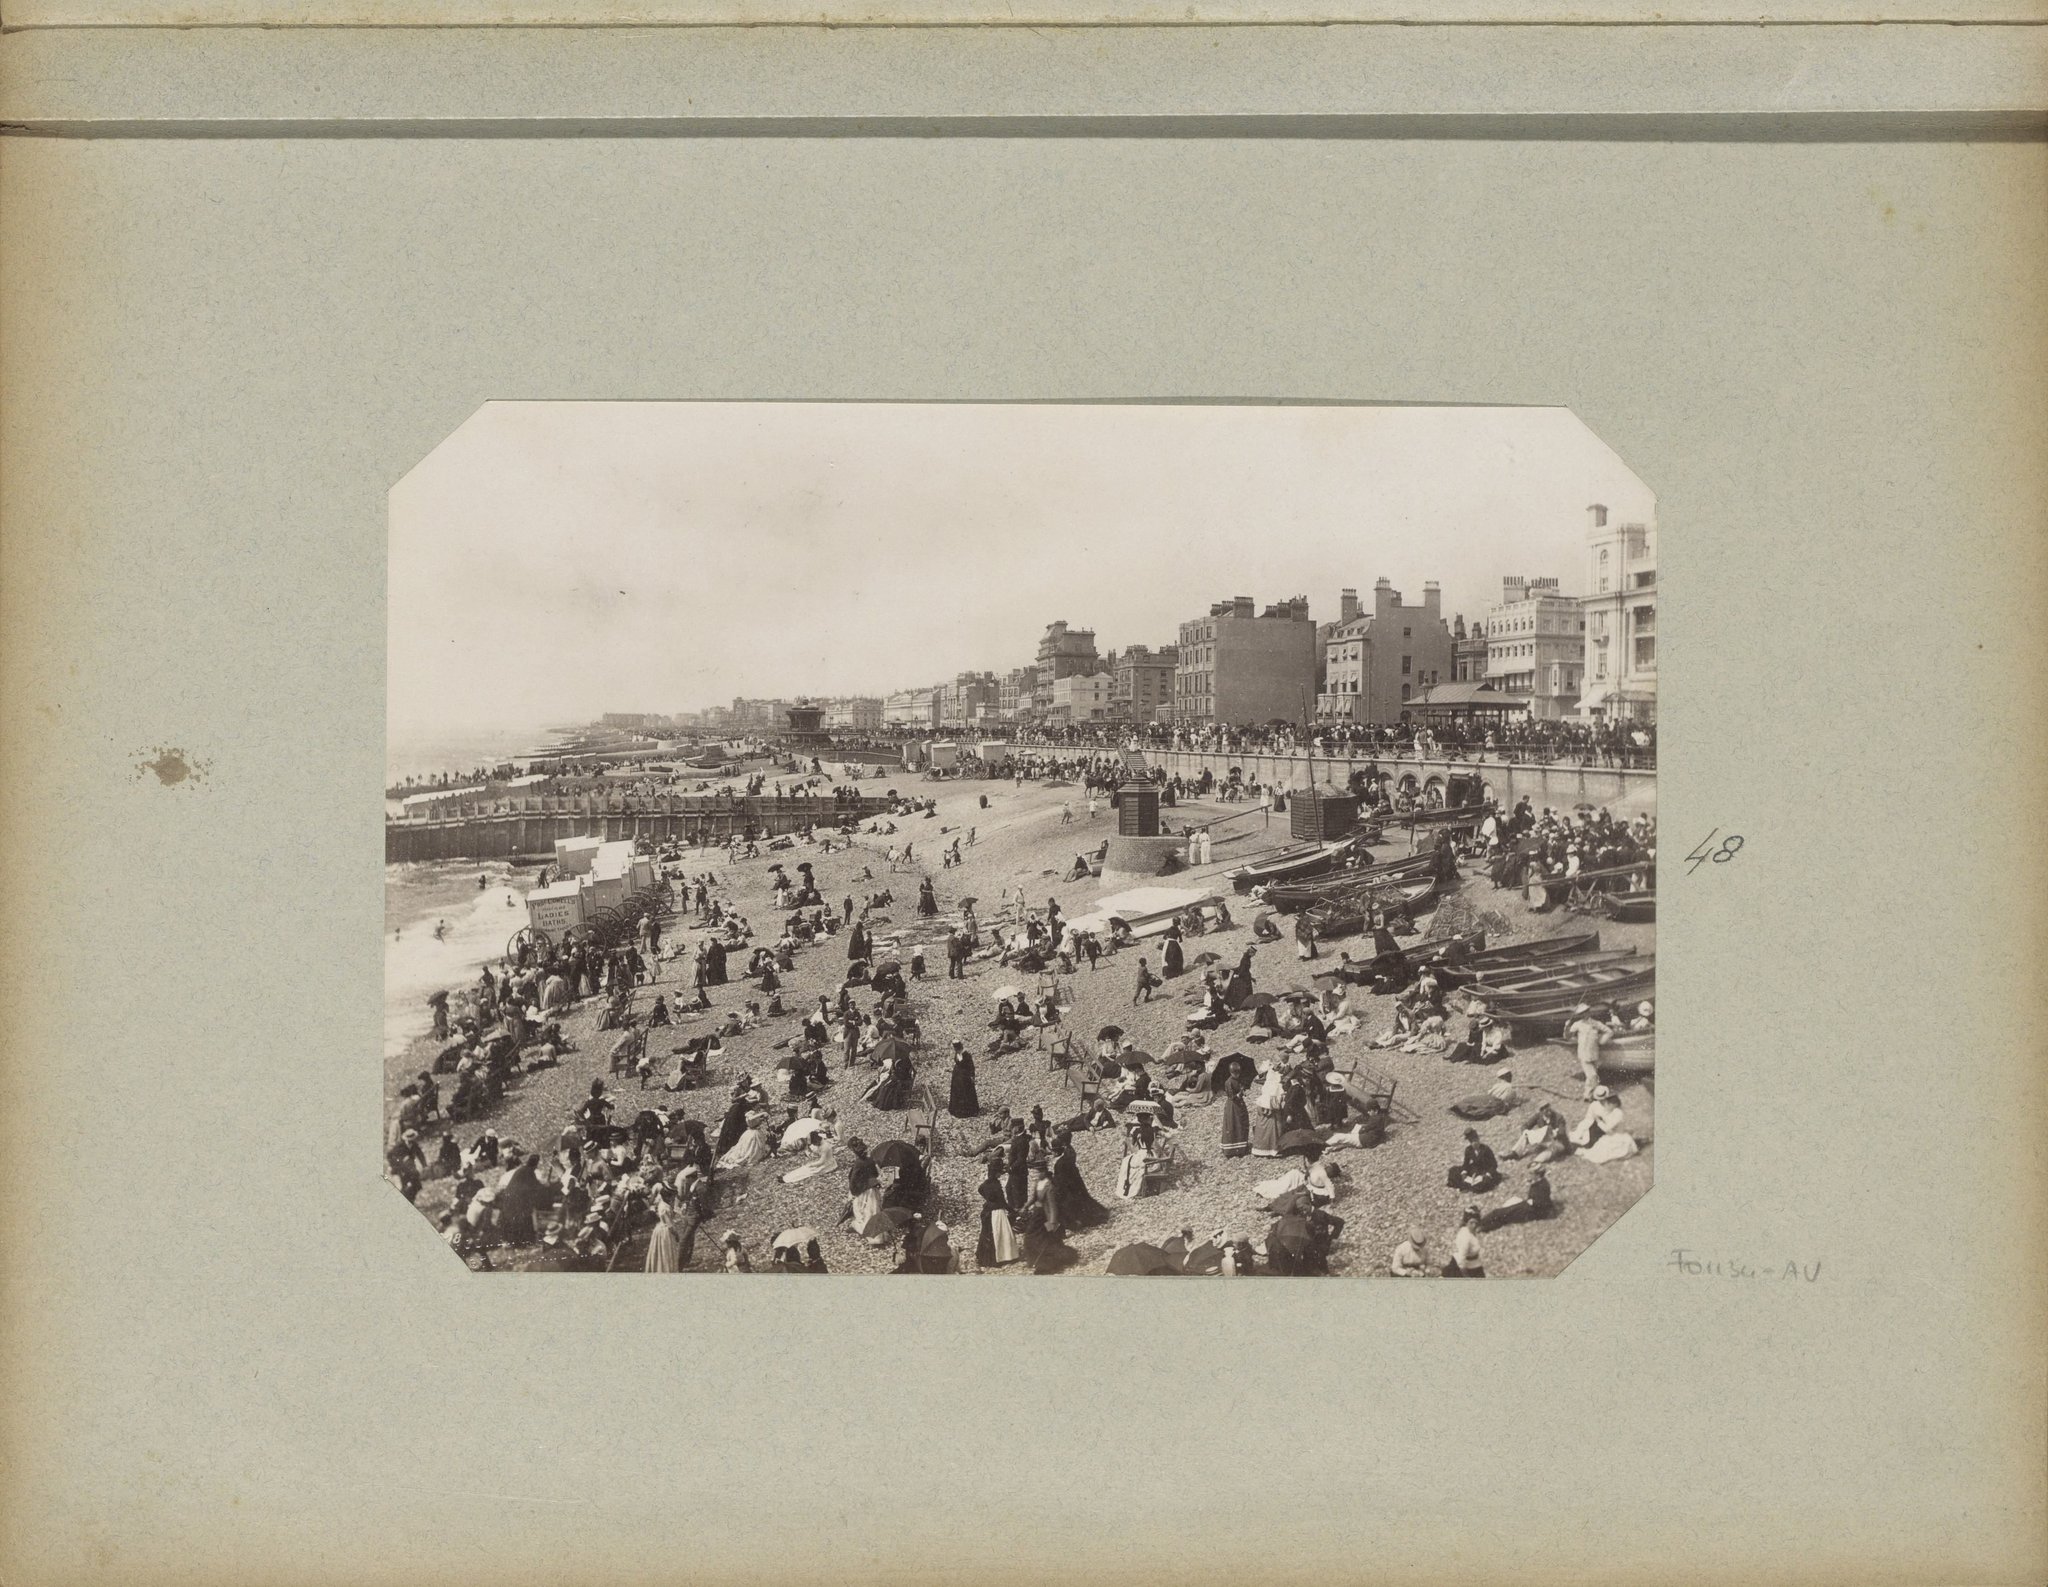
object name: photograph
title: Gezicht op het strand van Brighton met badgasten, badkoetsen, kade en gebouwen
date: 1880-1910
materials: paper, photographic support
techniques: albumen print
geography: brighton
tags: beach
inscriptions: check stamp: ‘Spooner & Co., 379, Strand, W.C.’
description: Onderdeel van Reisalbum met bezienswaardigheden in Engeland, Zwitserland, Frankrijk en Duitsland.